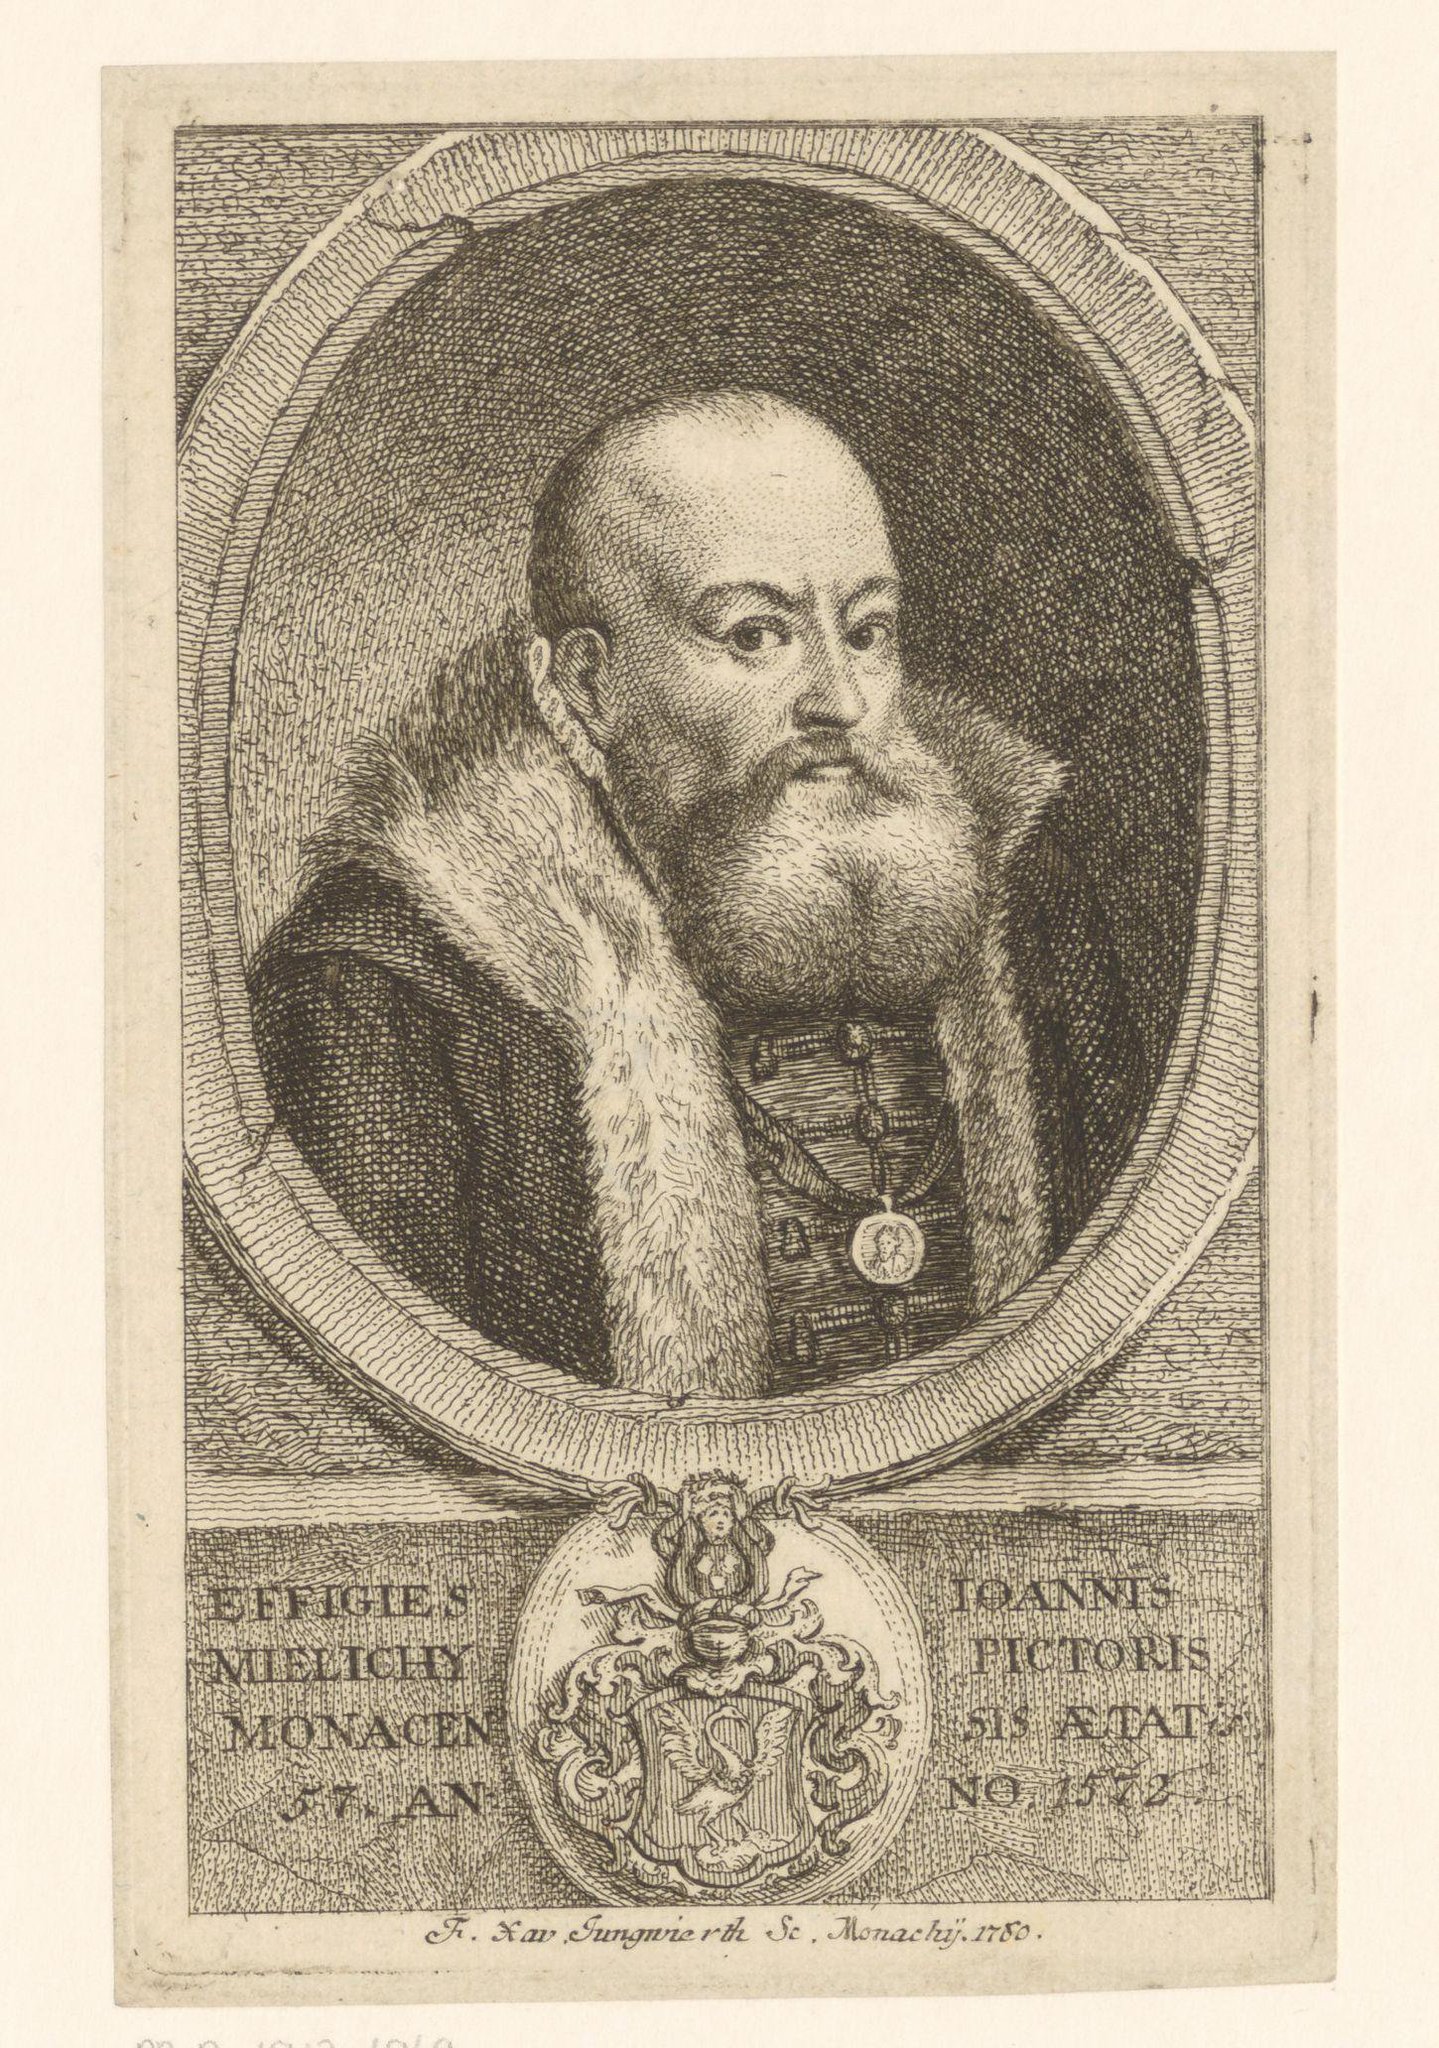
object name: print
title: Portret van Hans Mielich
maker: franz xaver jungwirth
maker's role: print maker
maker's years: 1720-1790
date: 1780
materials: paper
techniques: etching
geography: munich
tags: painter, hans mielich, historical persons, portrait, self-portrait of painter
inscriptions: collector's mark: Lugt 2228